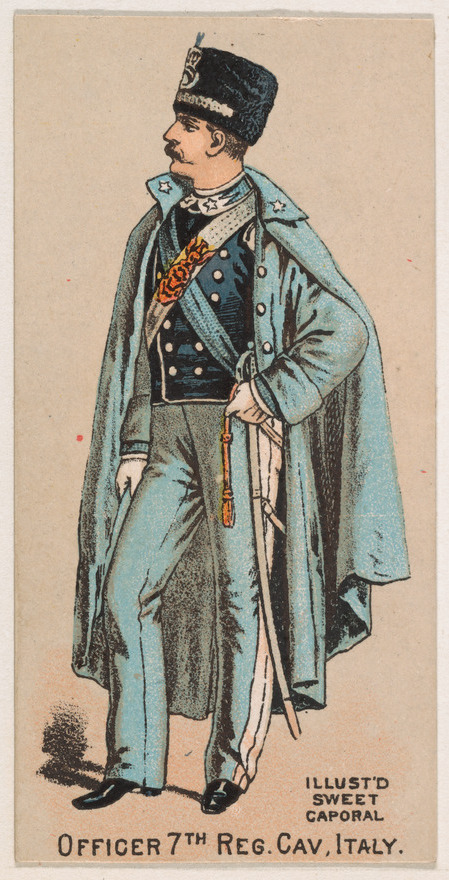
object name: print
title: Officer, 7th Reg. Cavalry, Italy, from the Military Series (N224) issued by Kinney Tobacco Company to promote Sweet Caporal Cigarettes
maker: kinney brothers tobacco company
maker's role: publisher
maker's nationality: american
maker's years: 1869-2011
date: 1888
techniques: color lithograph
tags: military,men,profiles